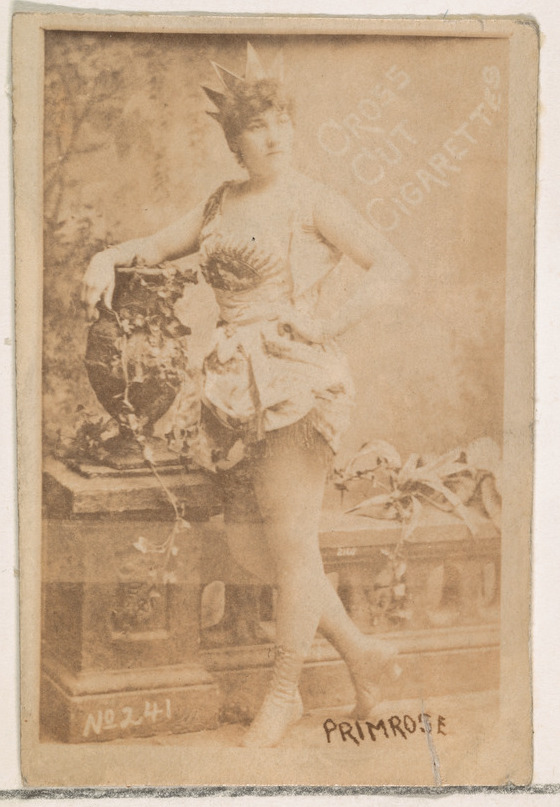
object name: print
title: Card Number 241, Primrose, from the Actors and Actresses series (N145-1) issued by Duke Sons & Co. to promote Cross Cut Cigarettes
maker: w. duke, sons & co.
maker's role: publisher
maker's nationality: american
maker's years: 1870-1920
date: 1880-1889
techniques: albumen silver print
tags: portraits,women,actresses